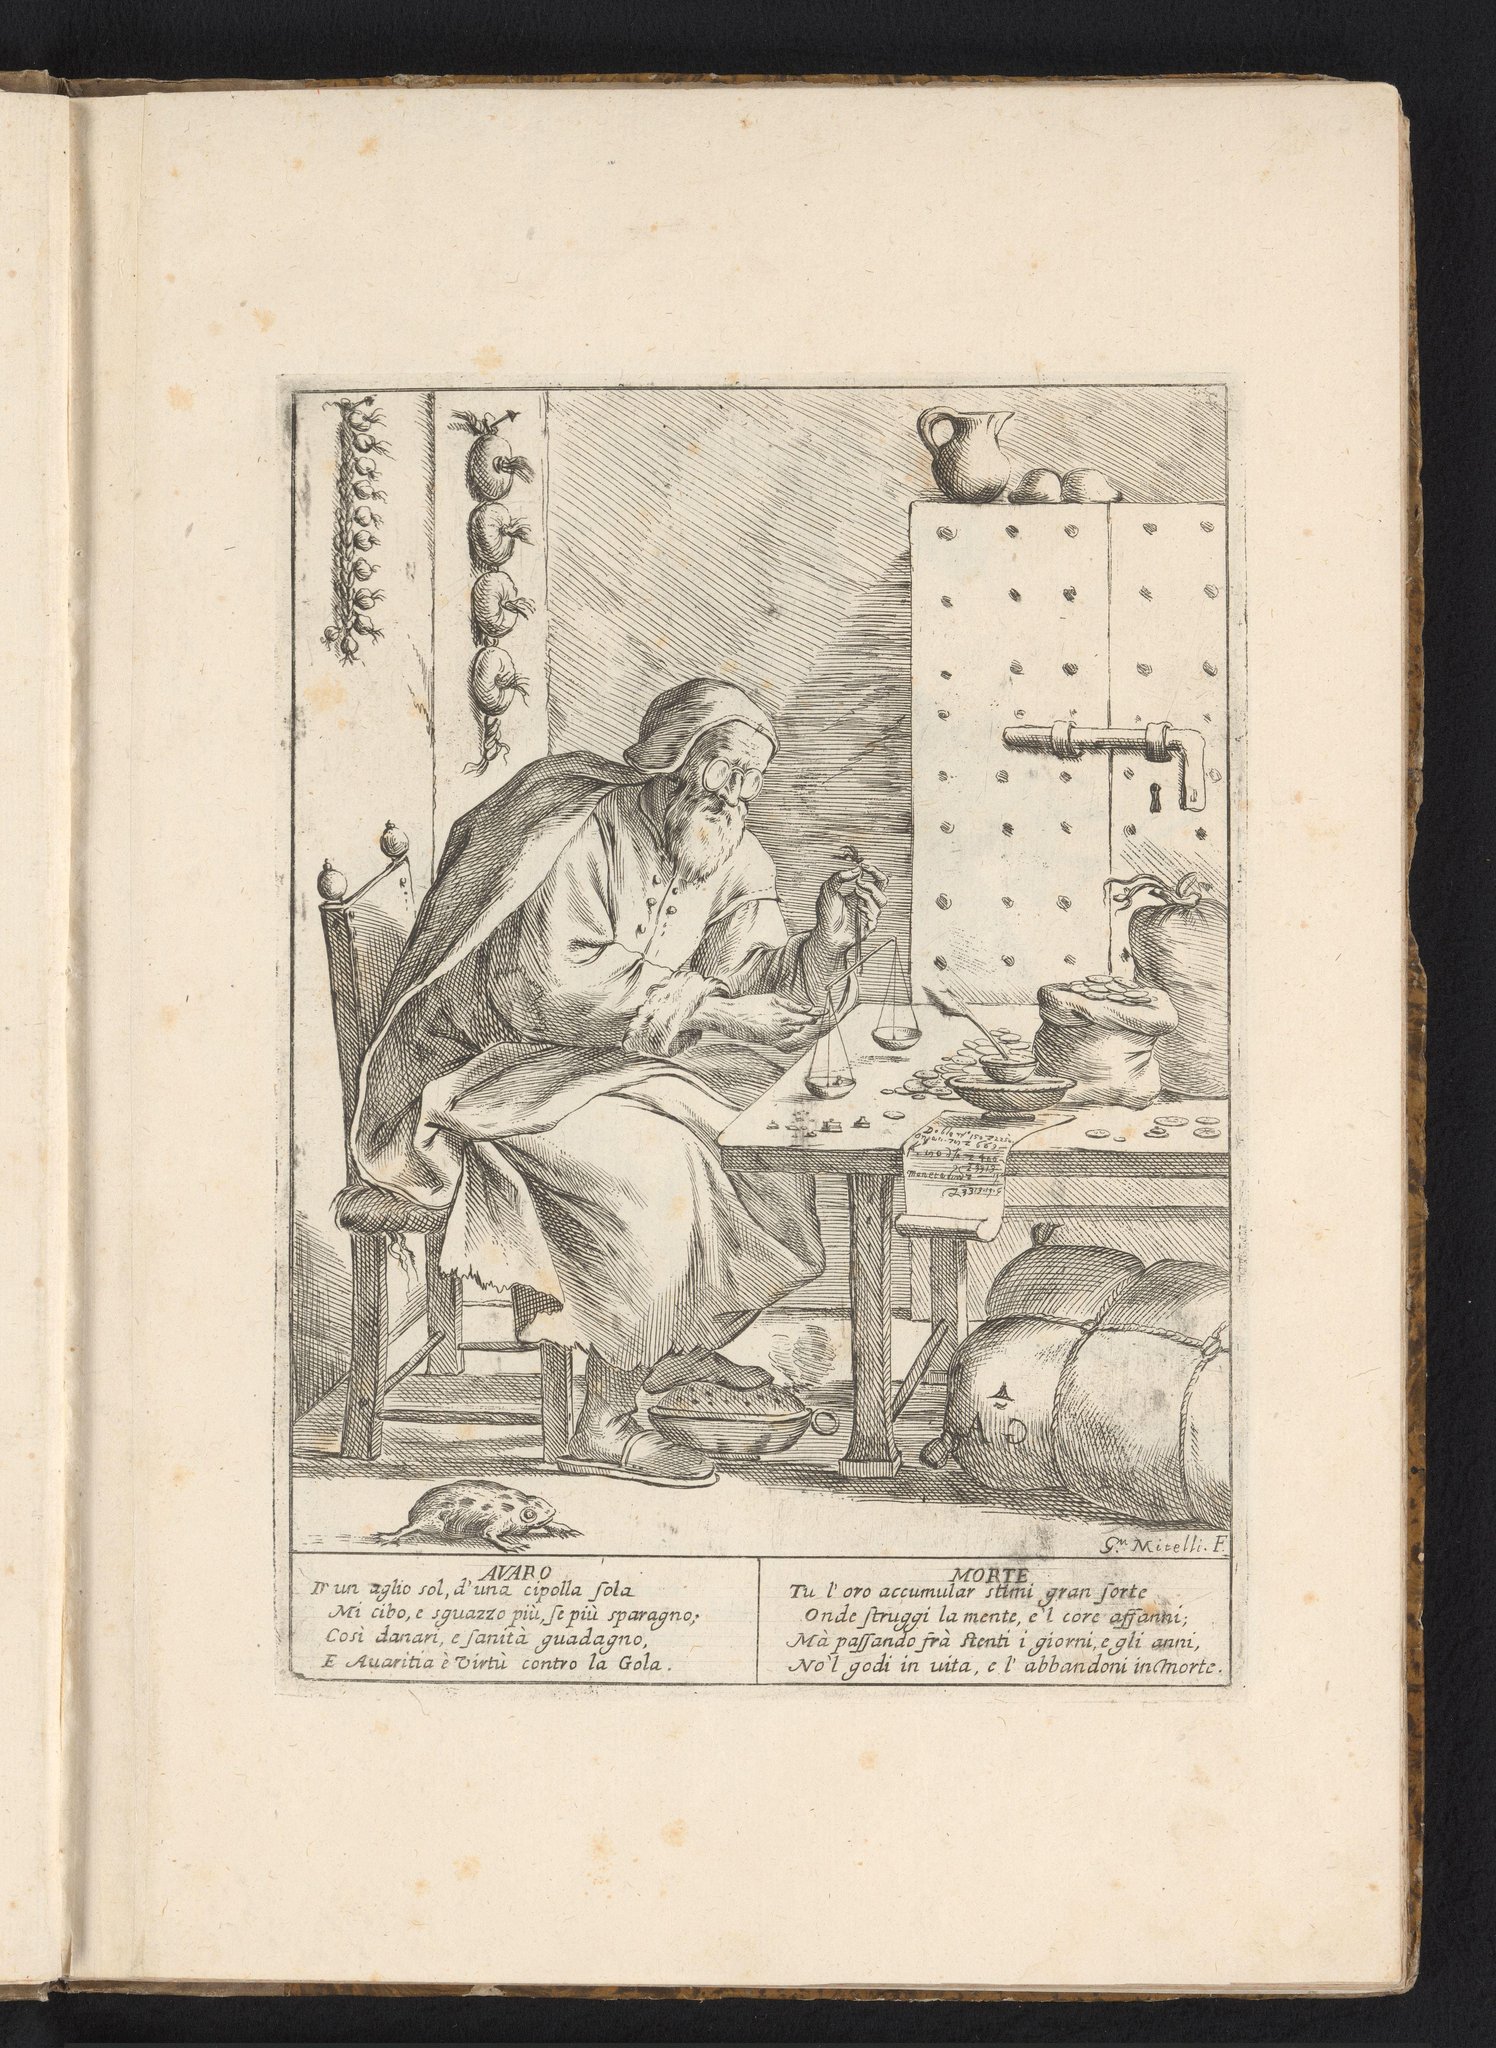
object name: print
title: De vierentwintig uren van het menselijk geluk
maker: giuseppe maria mitelli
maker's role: draughtsman, painter, print maker, publisher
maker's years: 1634-1718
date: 1675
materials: paper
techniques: engraving, etching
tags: tailless amphibians: frog, tailless amphibians: toad, scenes symbolizing 'vanitas', covetousness; 'avaritia' (ripa) ~ personification of one of the seven deadly sins, the 24 hours of day and night, safe, strongbox, coin, weighing gold or money, personifications ~ the life of man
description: Een gierige man (Avaro) met bril weegt geldstukken in zijn kantoor, met een voet op een stoof. op de voorgrond een pad of kikker. Aan de muur strengen knoflook. Voor de wand een kluis. Met twee vierregelige verzen in het Italiaans. Genummerd rechtsboven: 2. Onderdeel van de serie 'De vierentwintig uren van het menselijk geluk'.